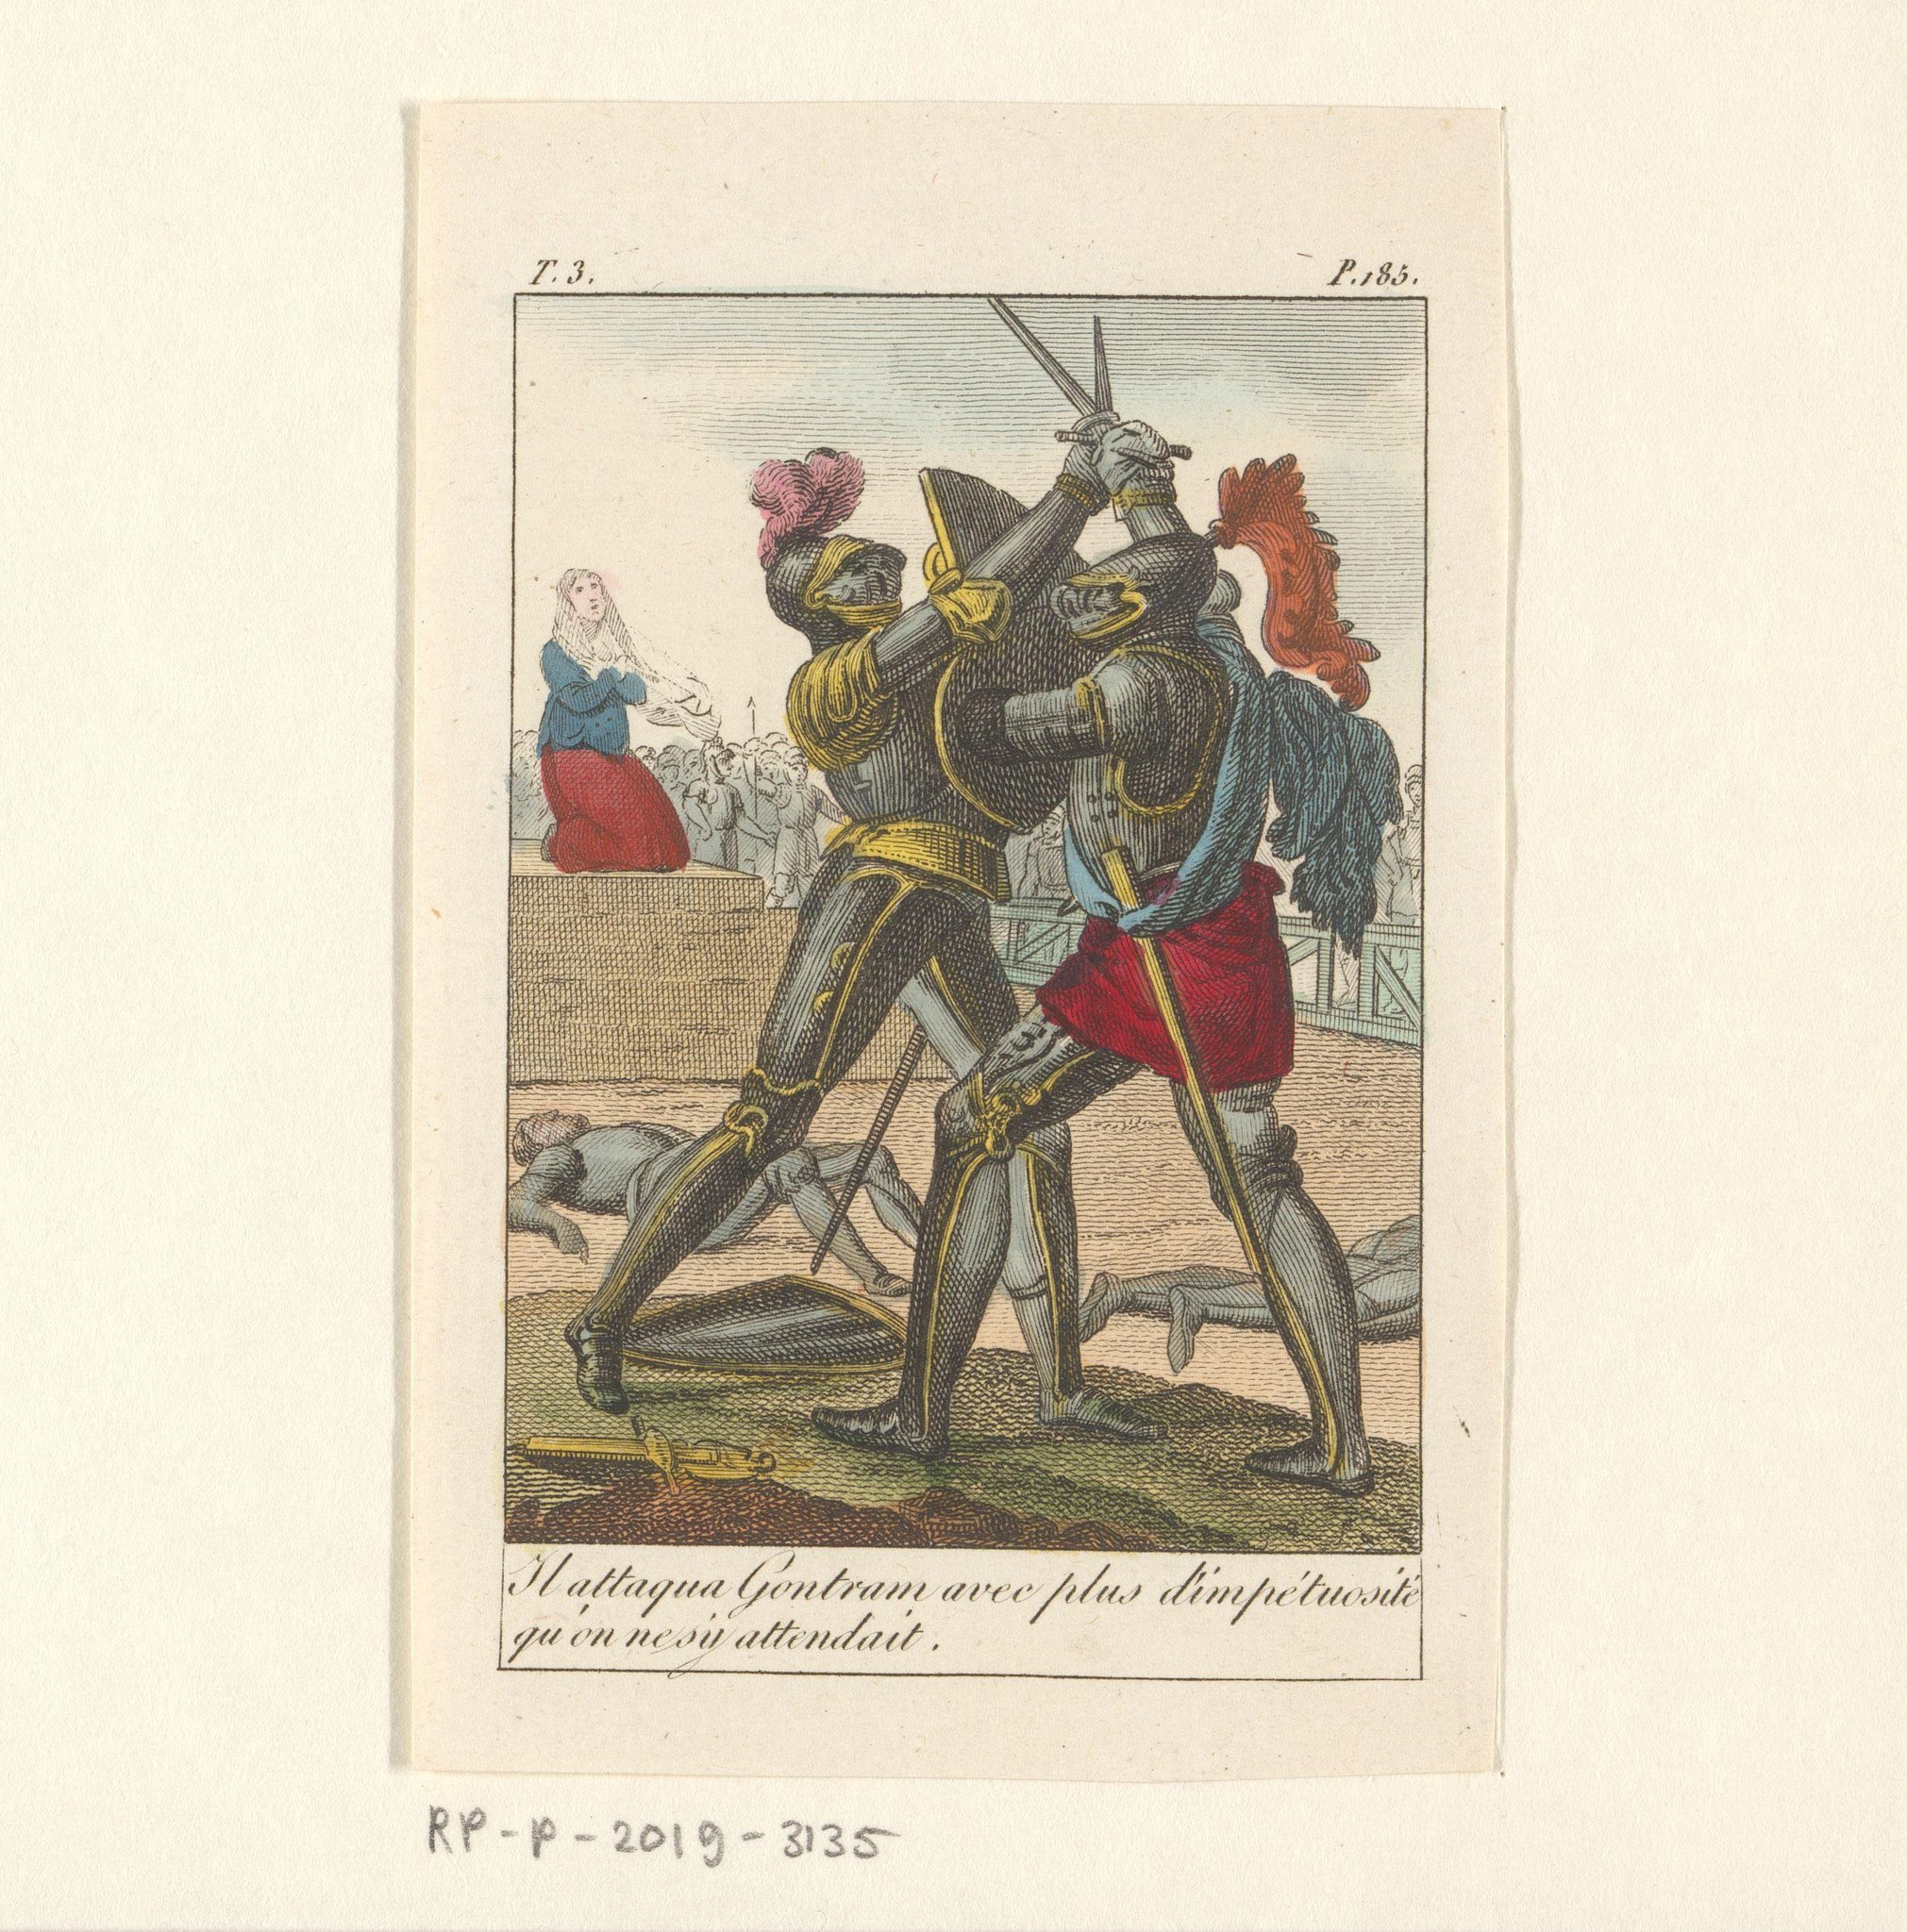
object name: book illustration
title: Twee ridders in gevecht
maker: Anonymous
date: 1800-1899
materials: paper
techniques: etching, hand coloring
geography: france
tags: duelling, knight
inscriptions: caption: ‘Il attaqua Gentram avec plus d 'impétuosité/ qu'en ne sy attendait.’, collector's mark: Lugt 2228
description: Prent uit deel drie van een onbekend boek, op p. 185.